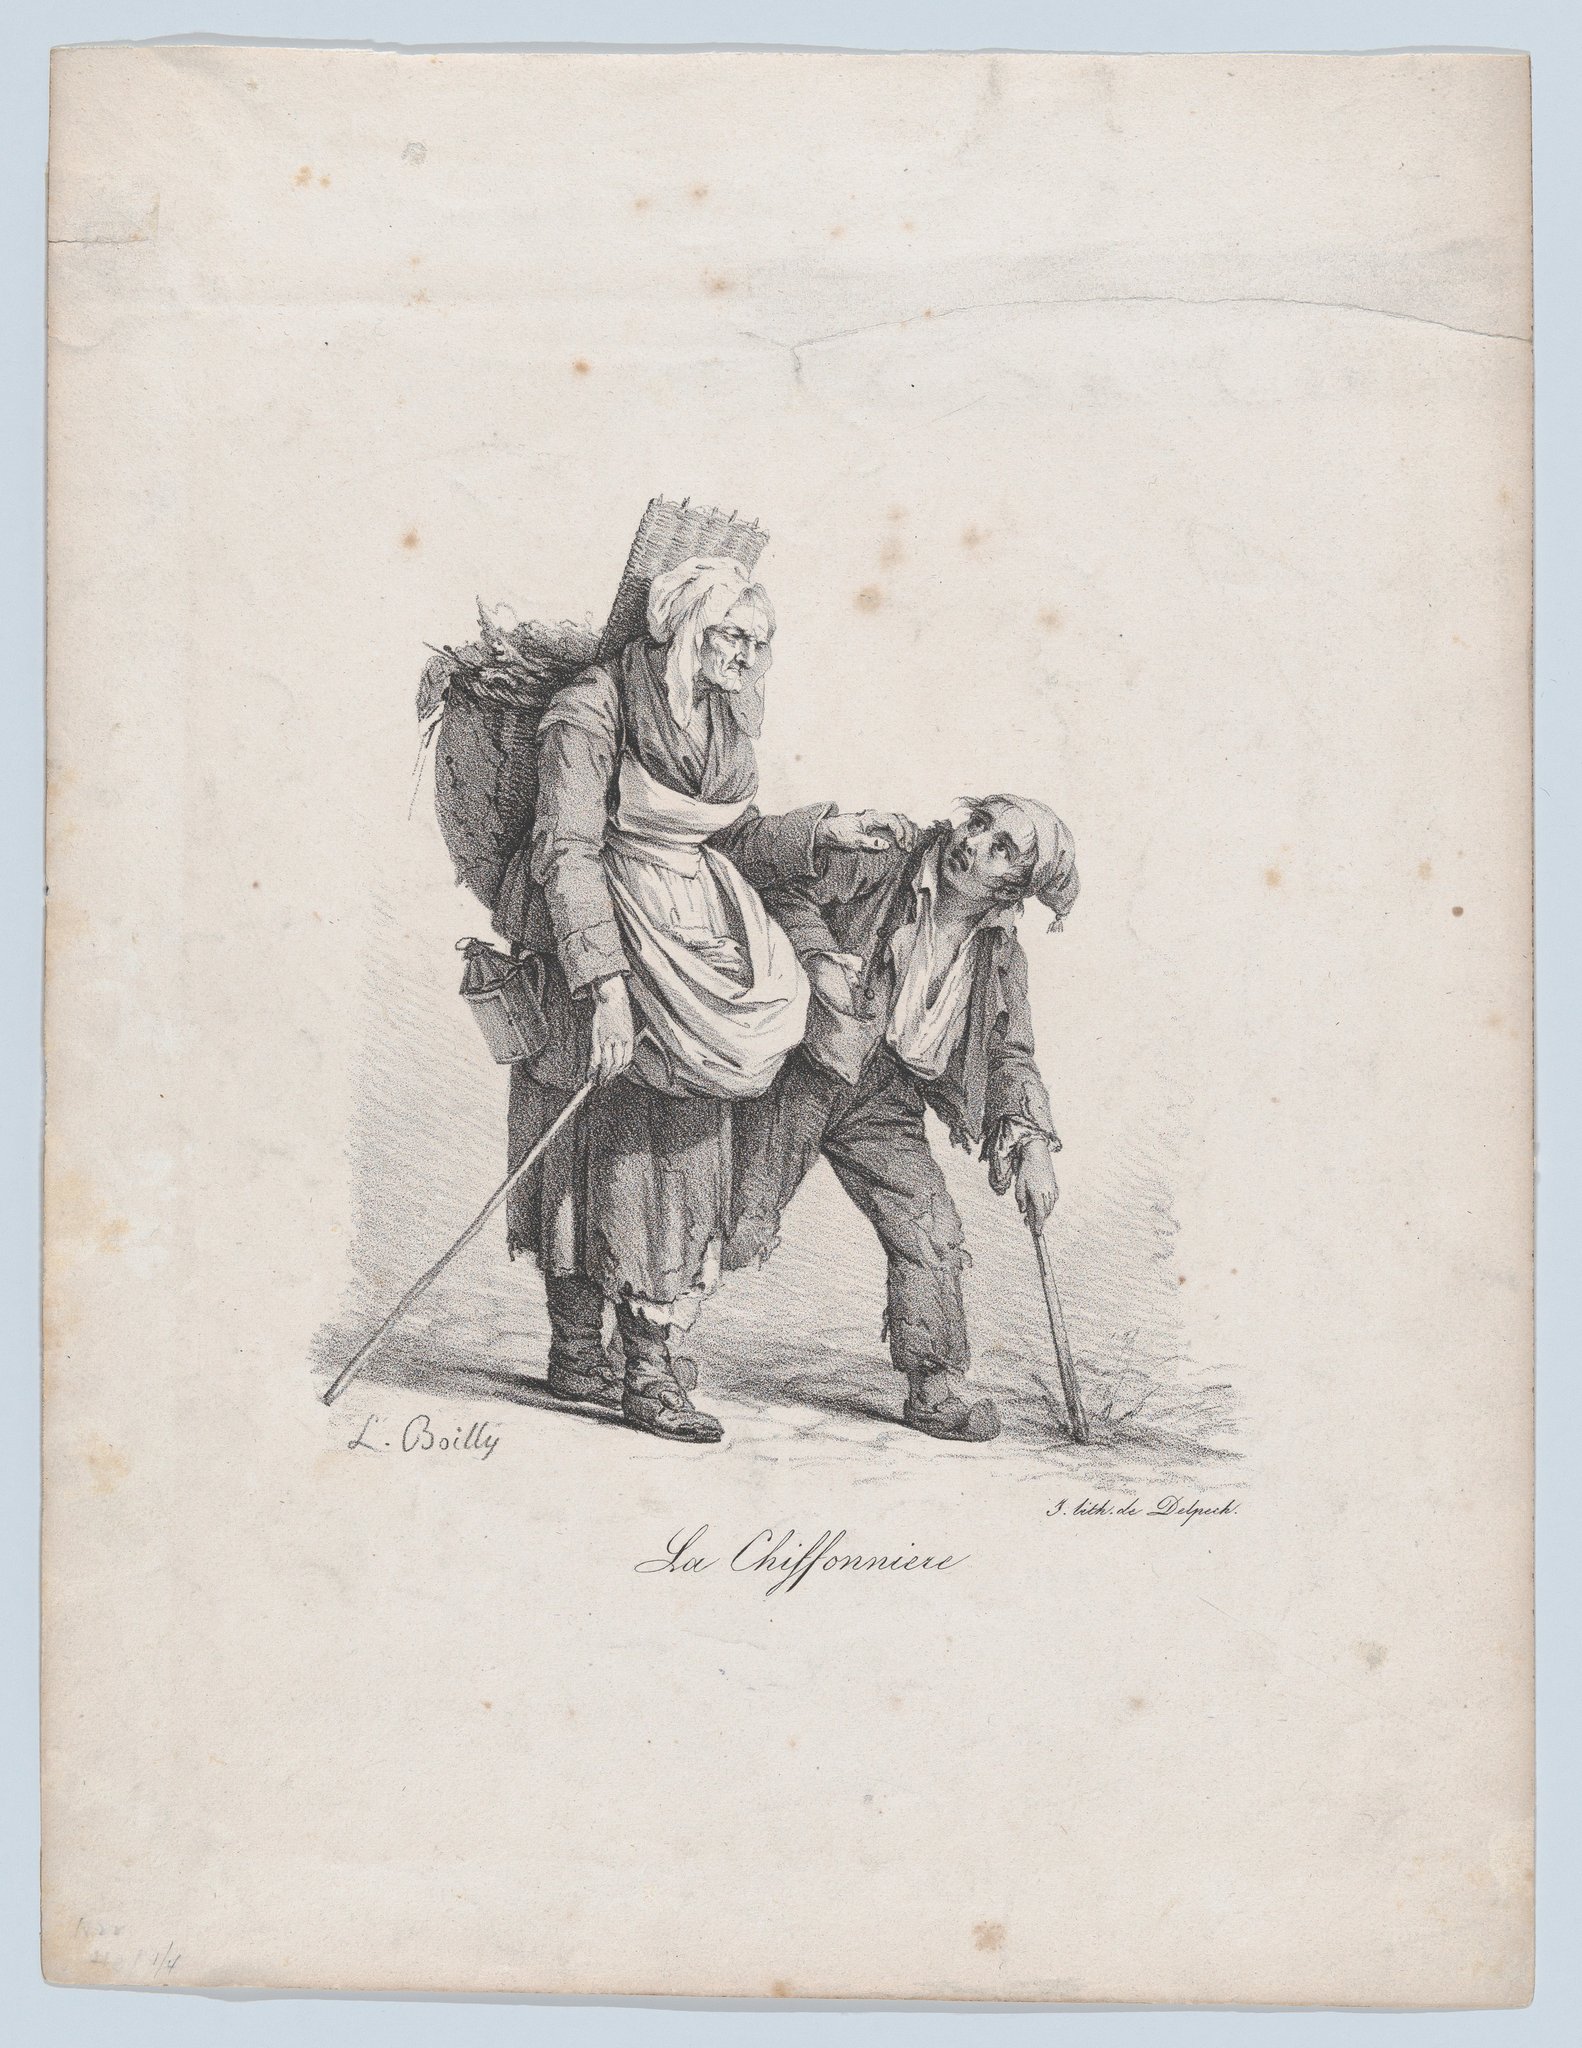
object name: print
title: The Rag Picker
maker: louis léopold boilly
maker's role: artist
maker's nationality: french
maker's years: 1761-1845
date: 1822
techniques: lithograph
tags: men,women